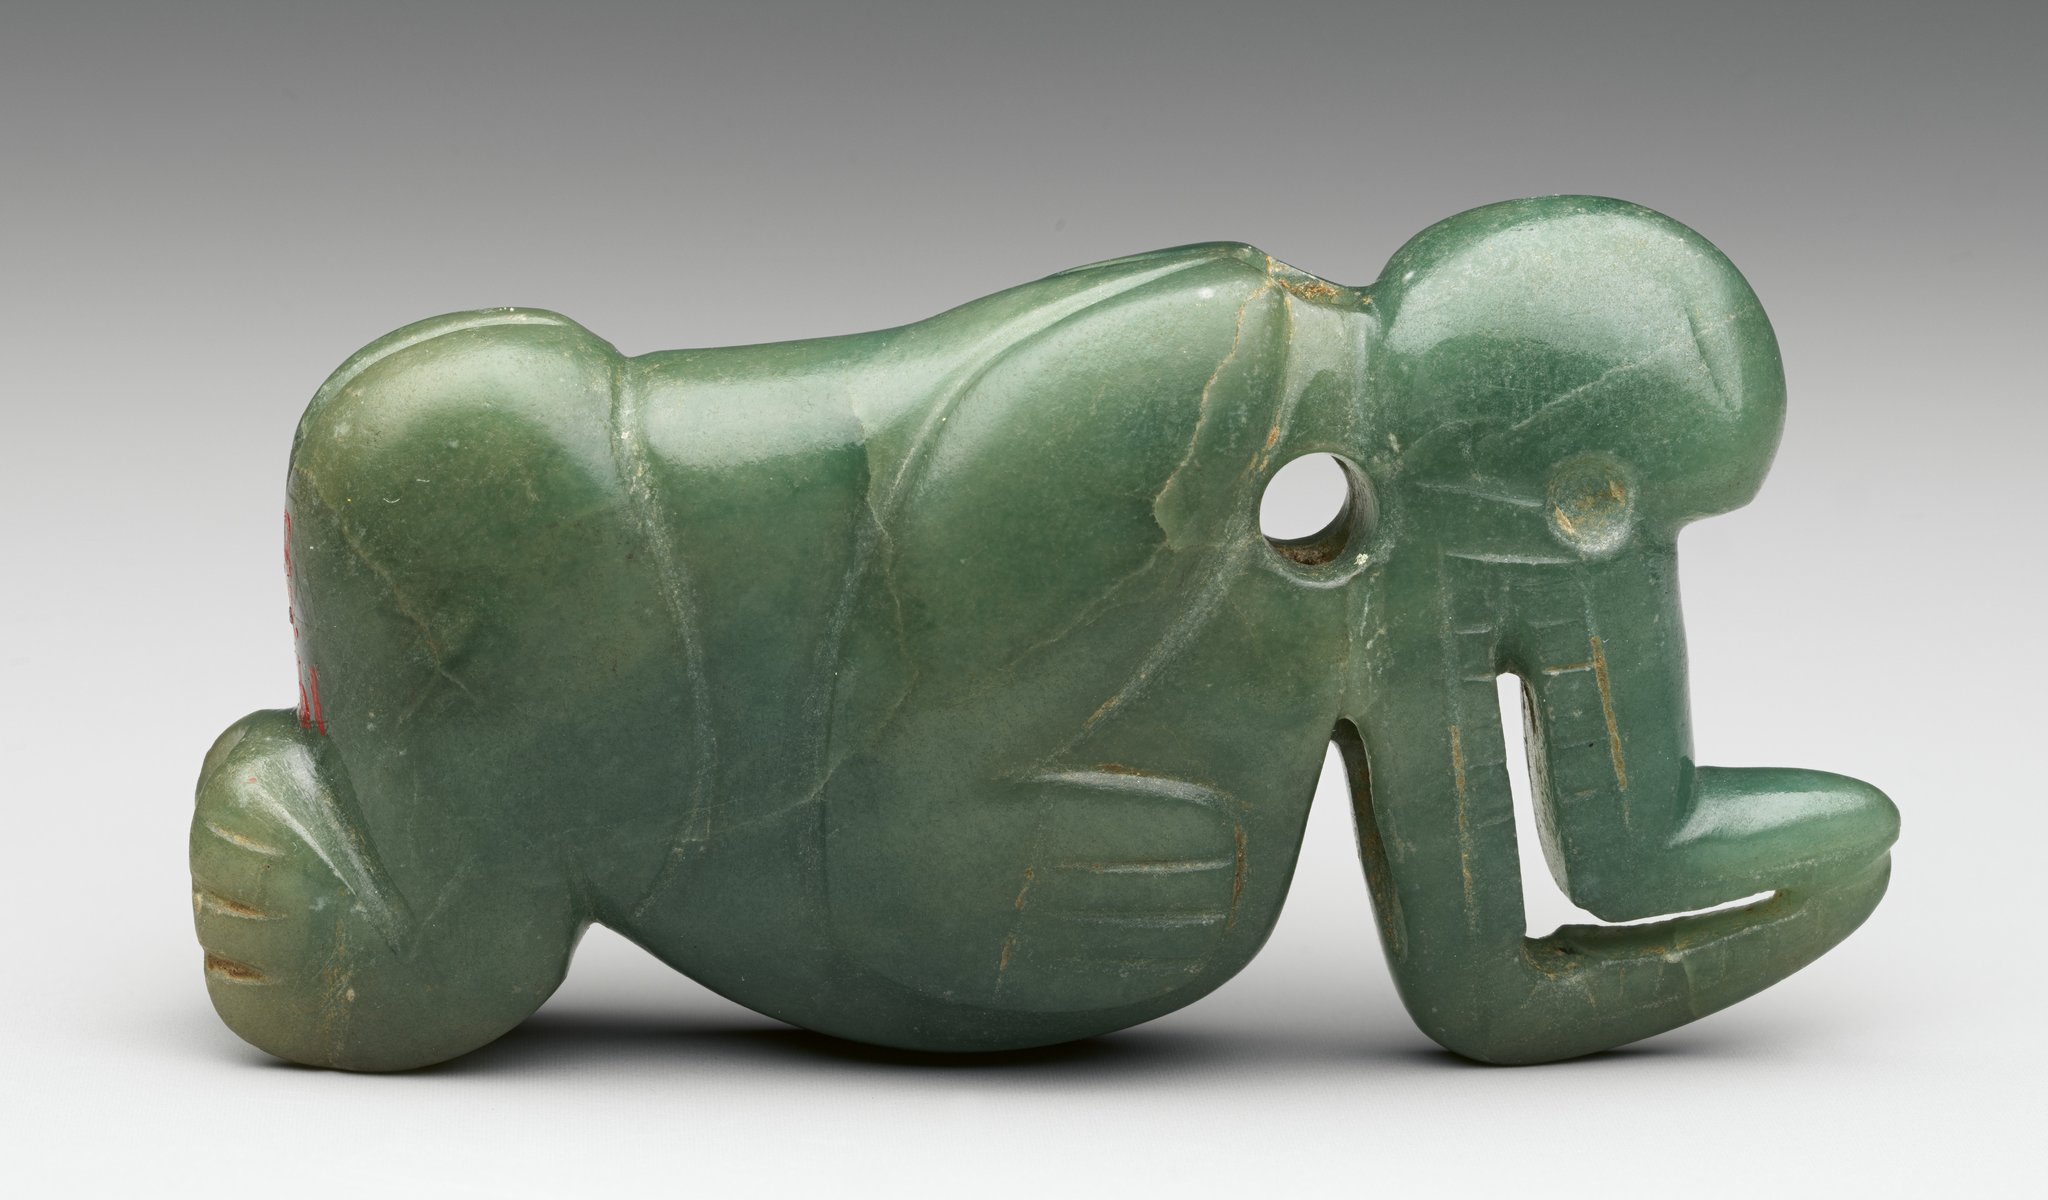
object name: pendant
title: Masked Figure Pendant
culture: atlantic watershed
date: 301-800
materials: jade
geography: costa rica